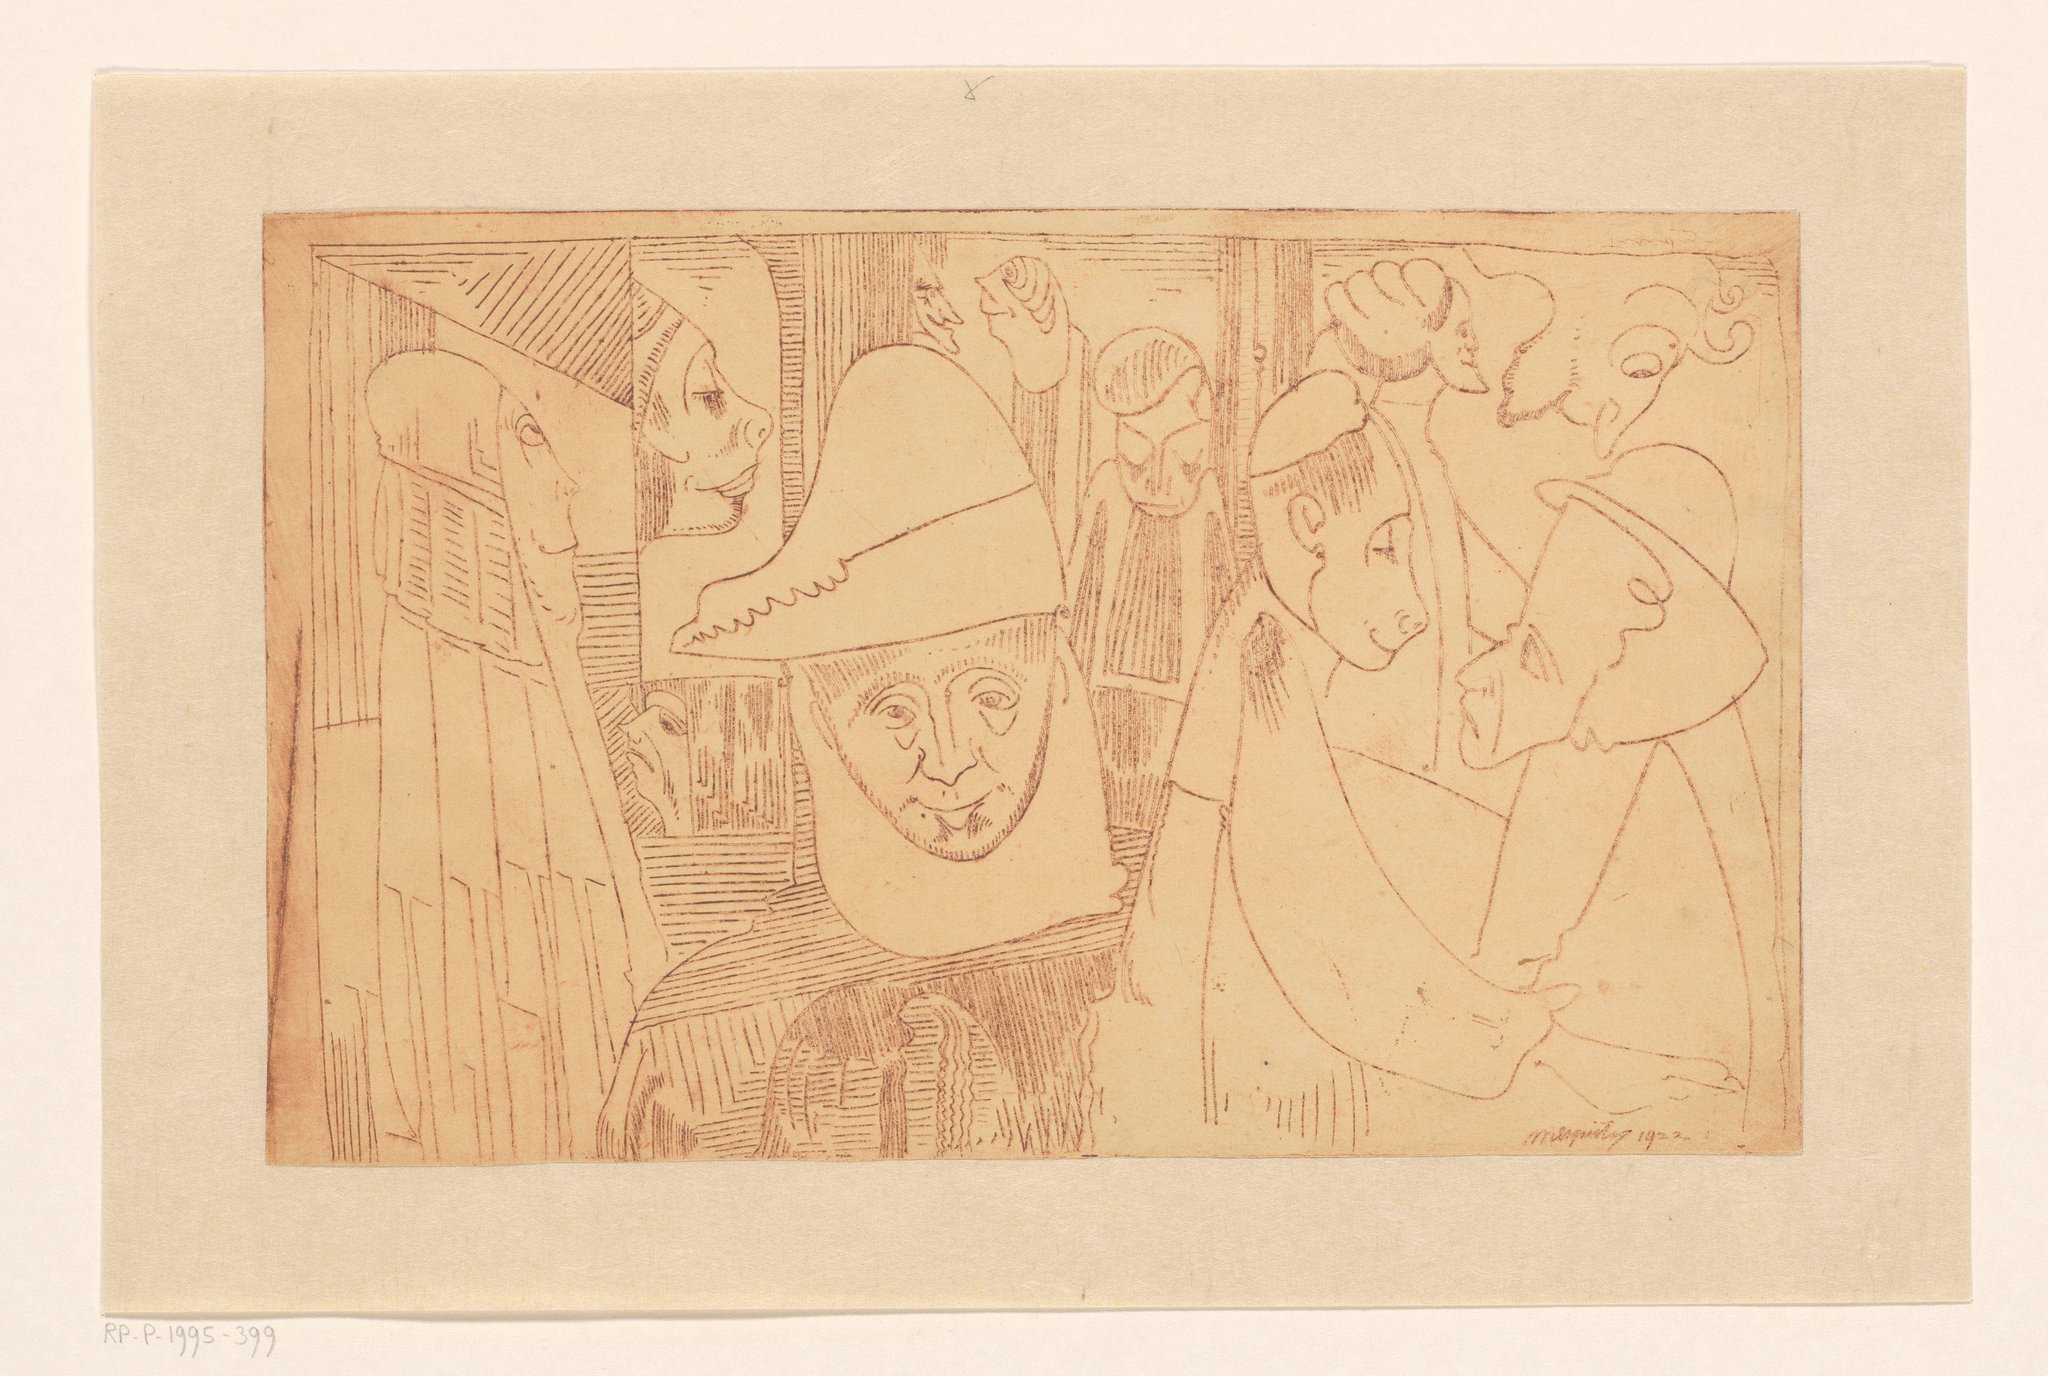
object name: print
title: Elf koppen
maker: samuel jessurun de mesquita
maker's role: draughtsman, print maker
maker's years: 1868-1944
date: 1922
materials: paper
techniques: etching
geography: netherlands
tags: caricatures (human types), head-gear: hat, dress, gown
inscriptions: collector's mark: Lugt 2228